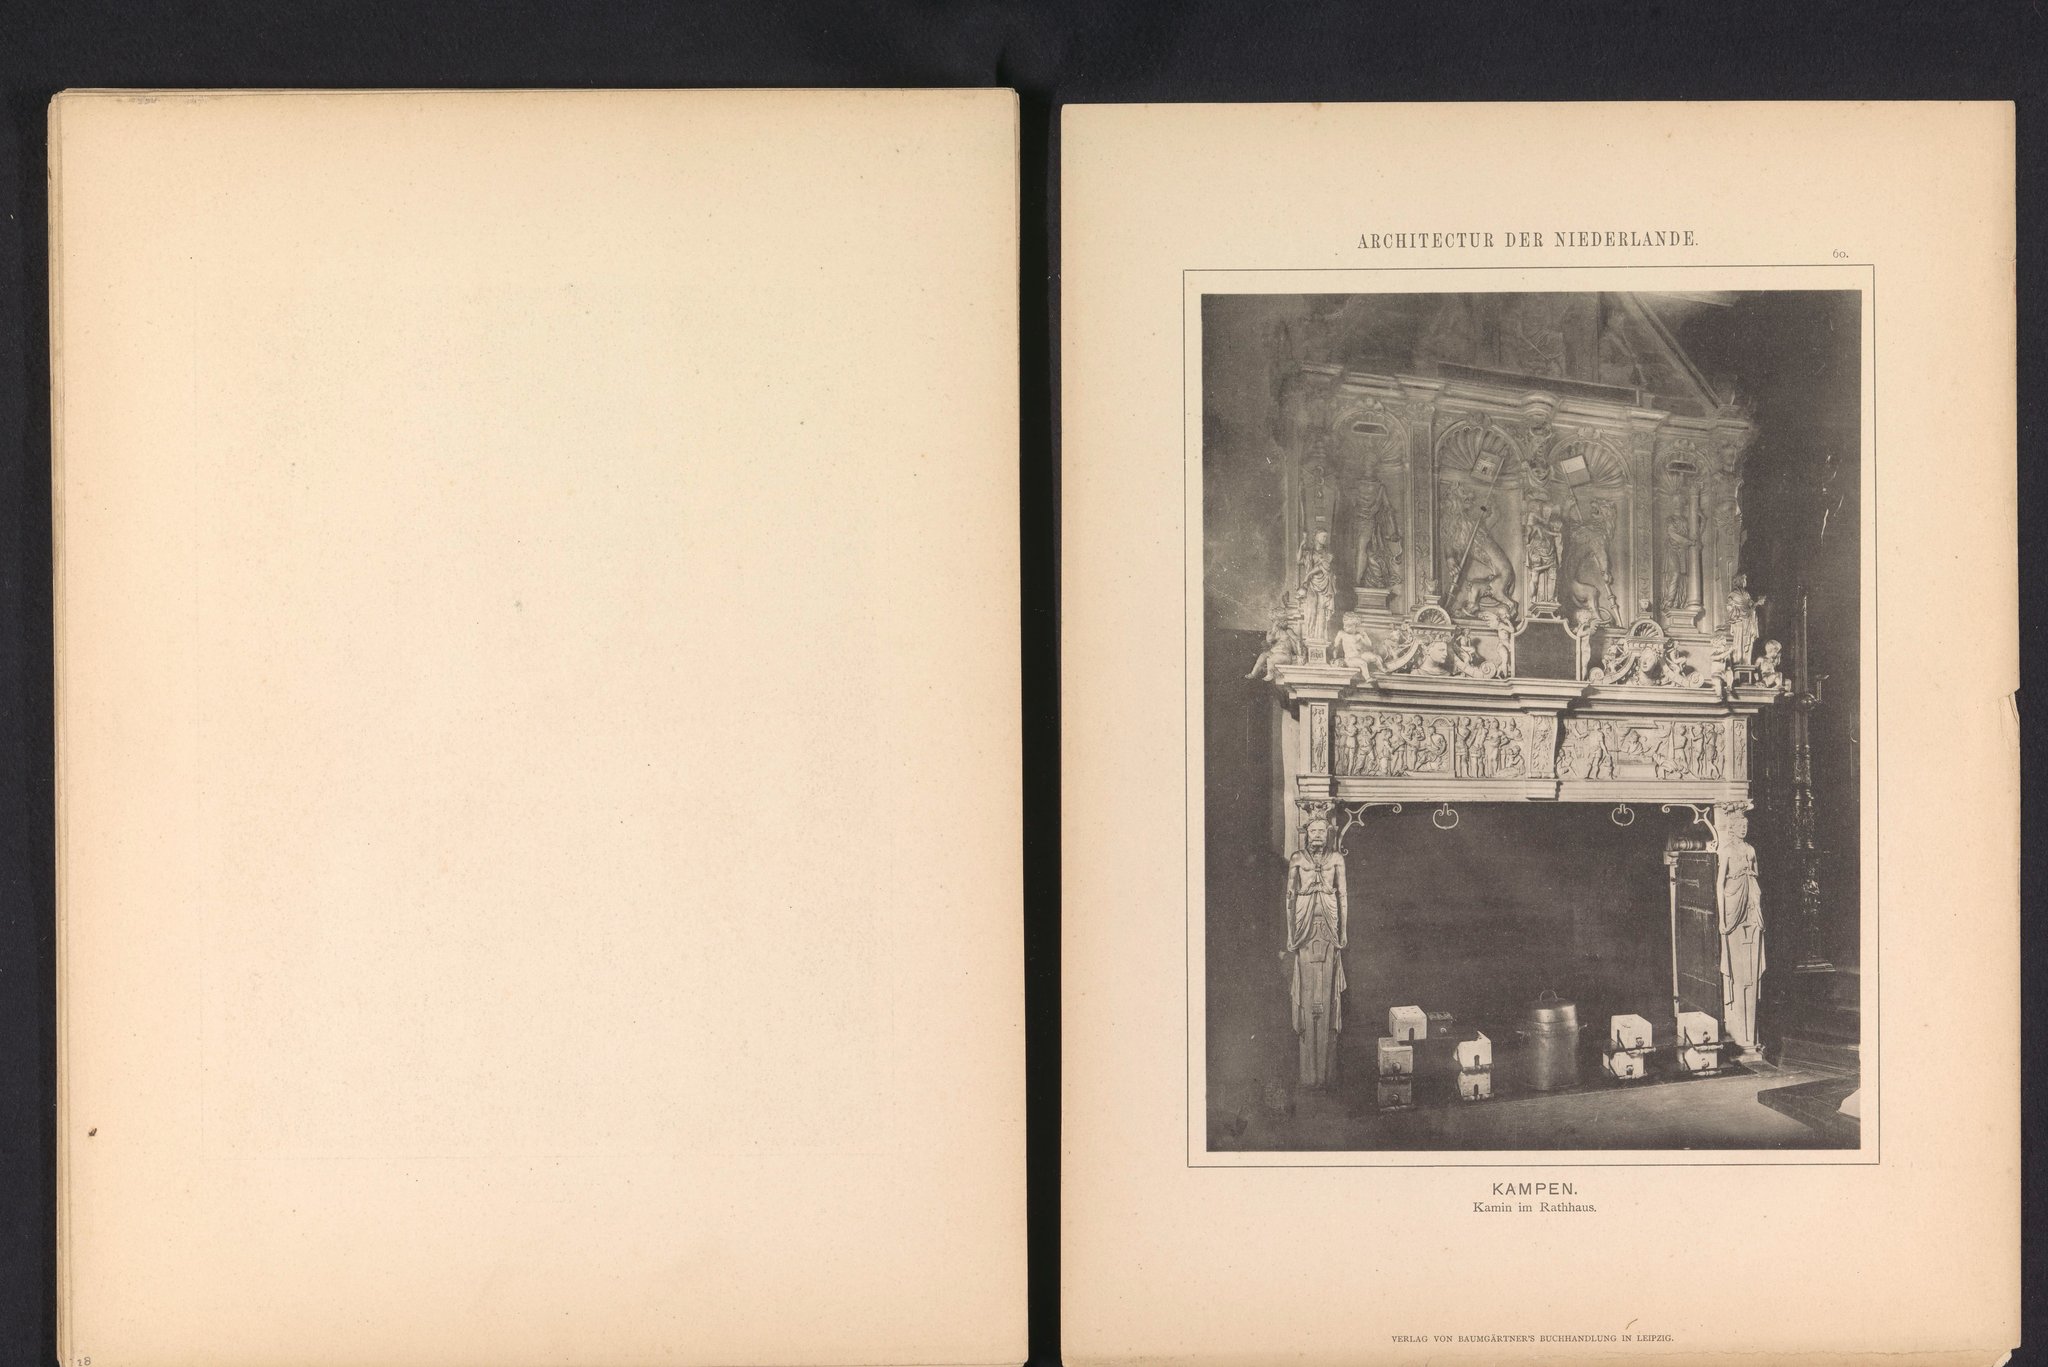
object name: photomechanical print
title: Kampen. Kamin im Rathhaus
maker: Anonymous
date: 1884-1894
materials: paper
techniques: photograph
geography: leipzig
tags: open hearth, fire-place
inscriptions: number: ‘60.’